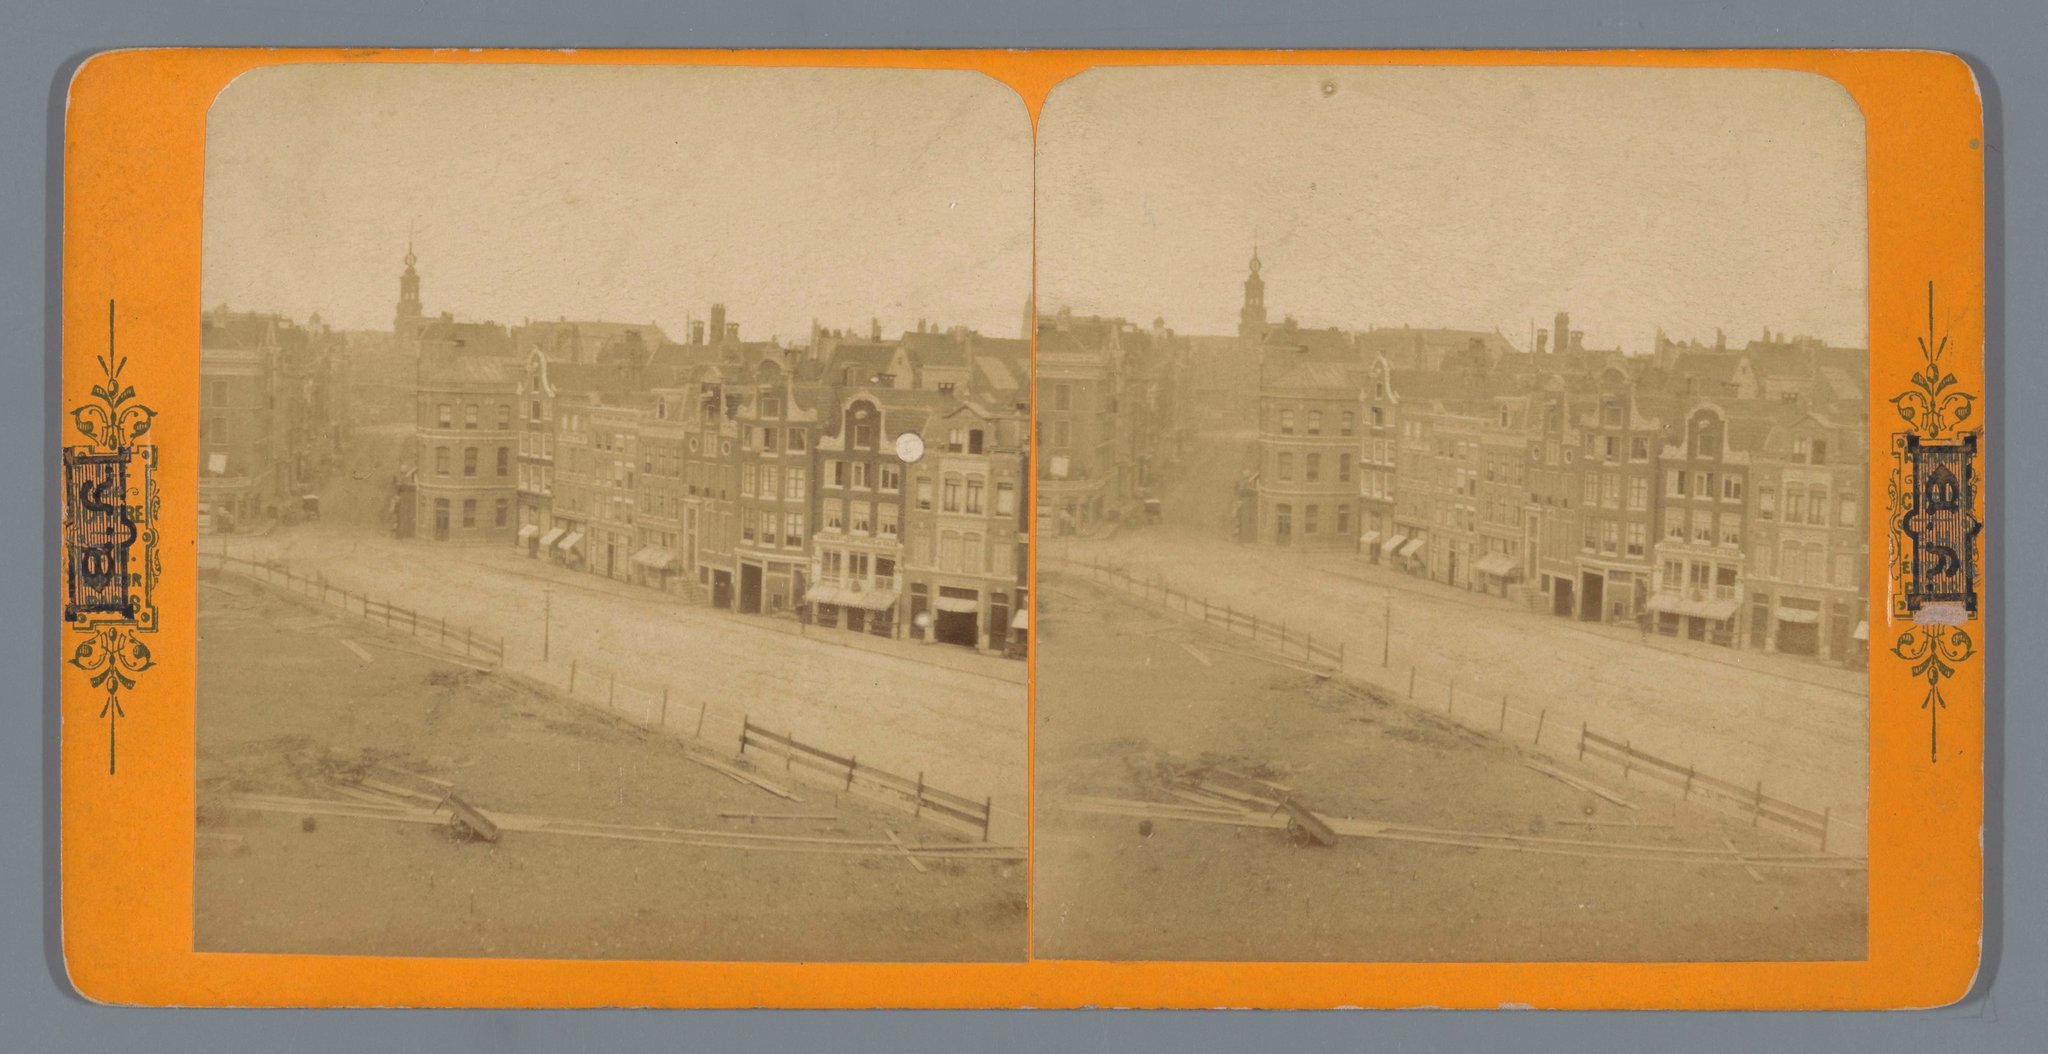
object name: stereograph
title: Gezicht op het Rembrandtplein in Amsterdam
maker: e.l.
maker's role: publisher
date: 1850-1880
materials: cardboard, photographic support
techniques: albumen print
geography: rembrandtplein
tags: village square, place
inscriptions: annotation: ‘I’, annotation: ‘Place Rembrandt -/ Amsterdam’